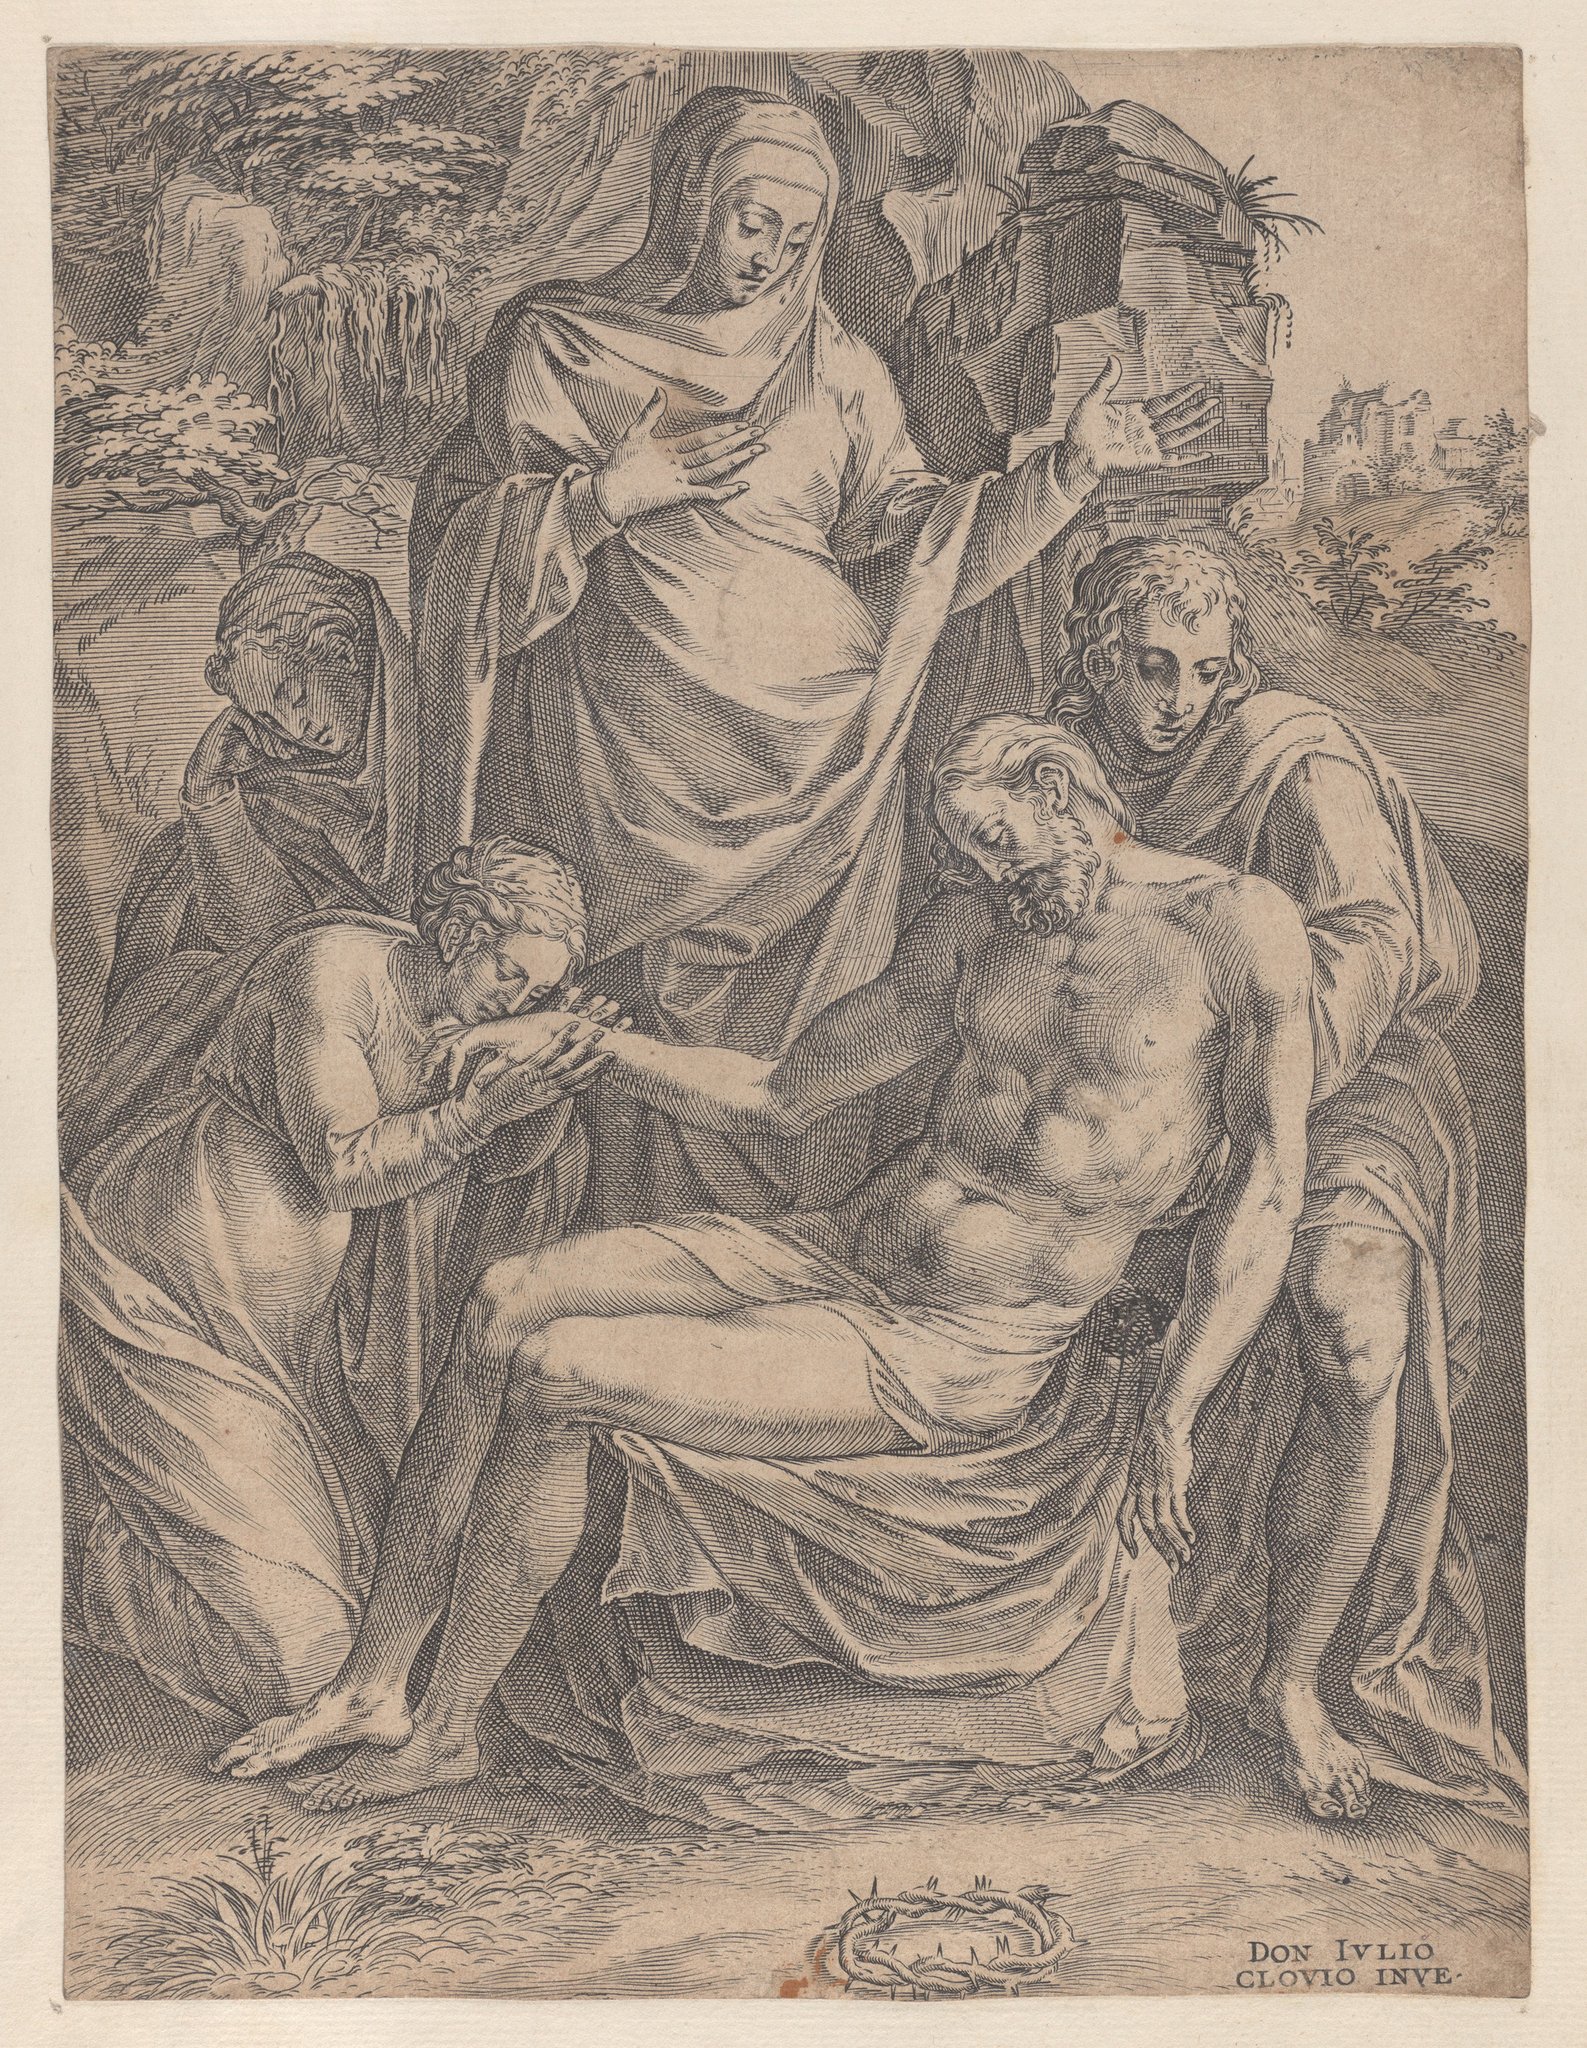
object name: print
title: The Entombment of Christ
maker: Anonymous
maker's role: artist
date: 1570-1580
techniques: engraving